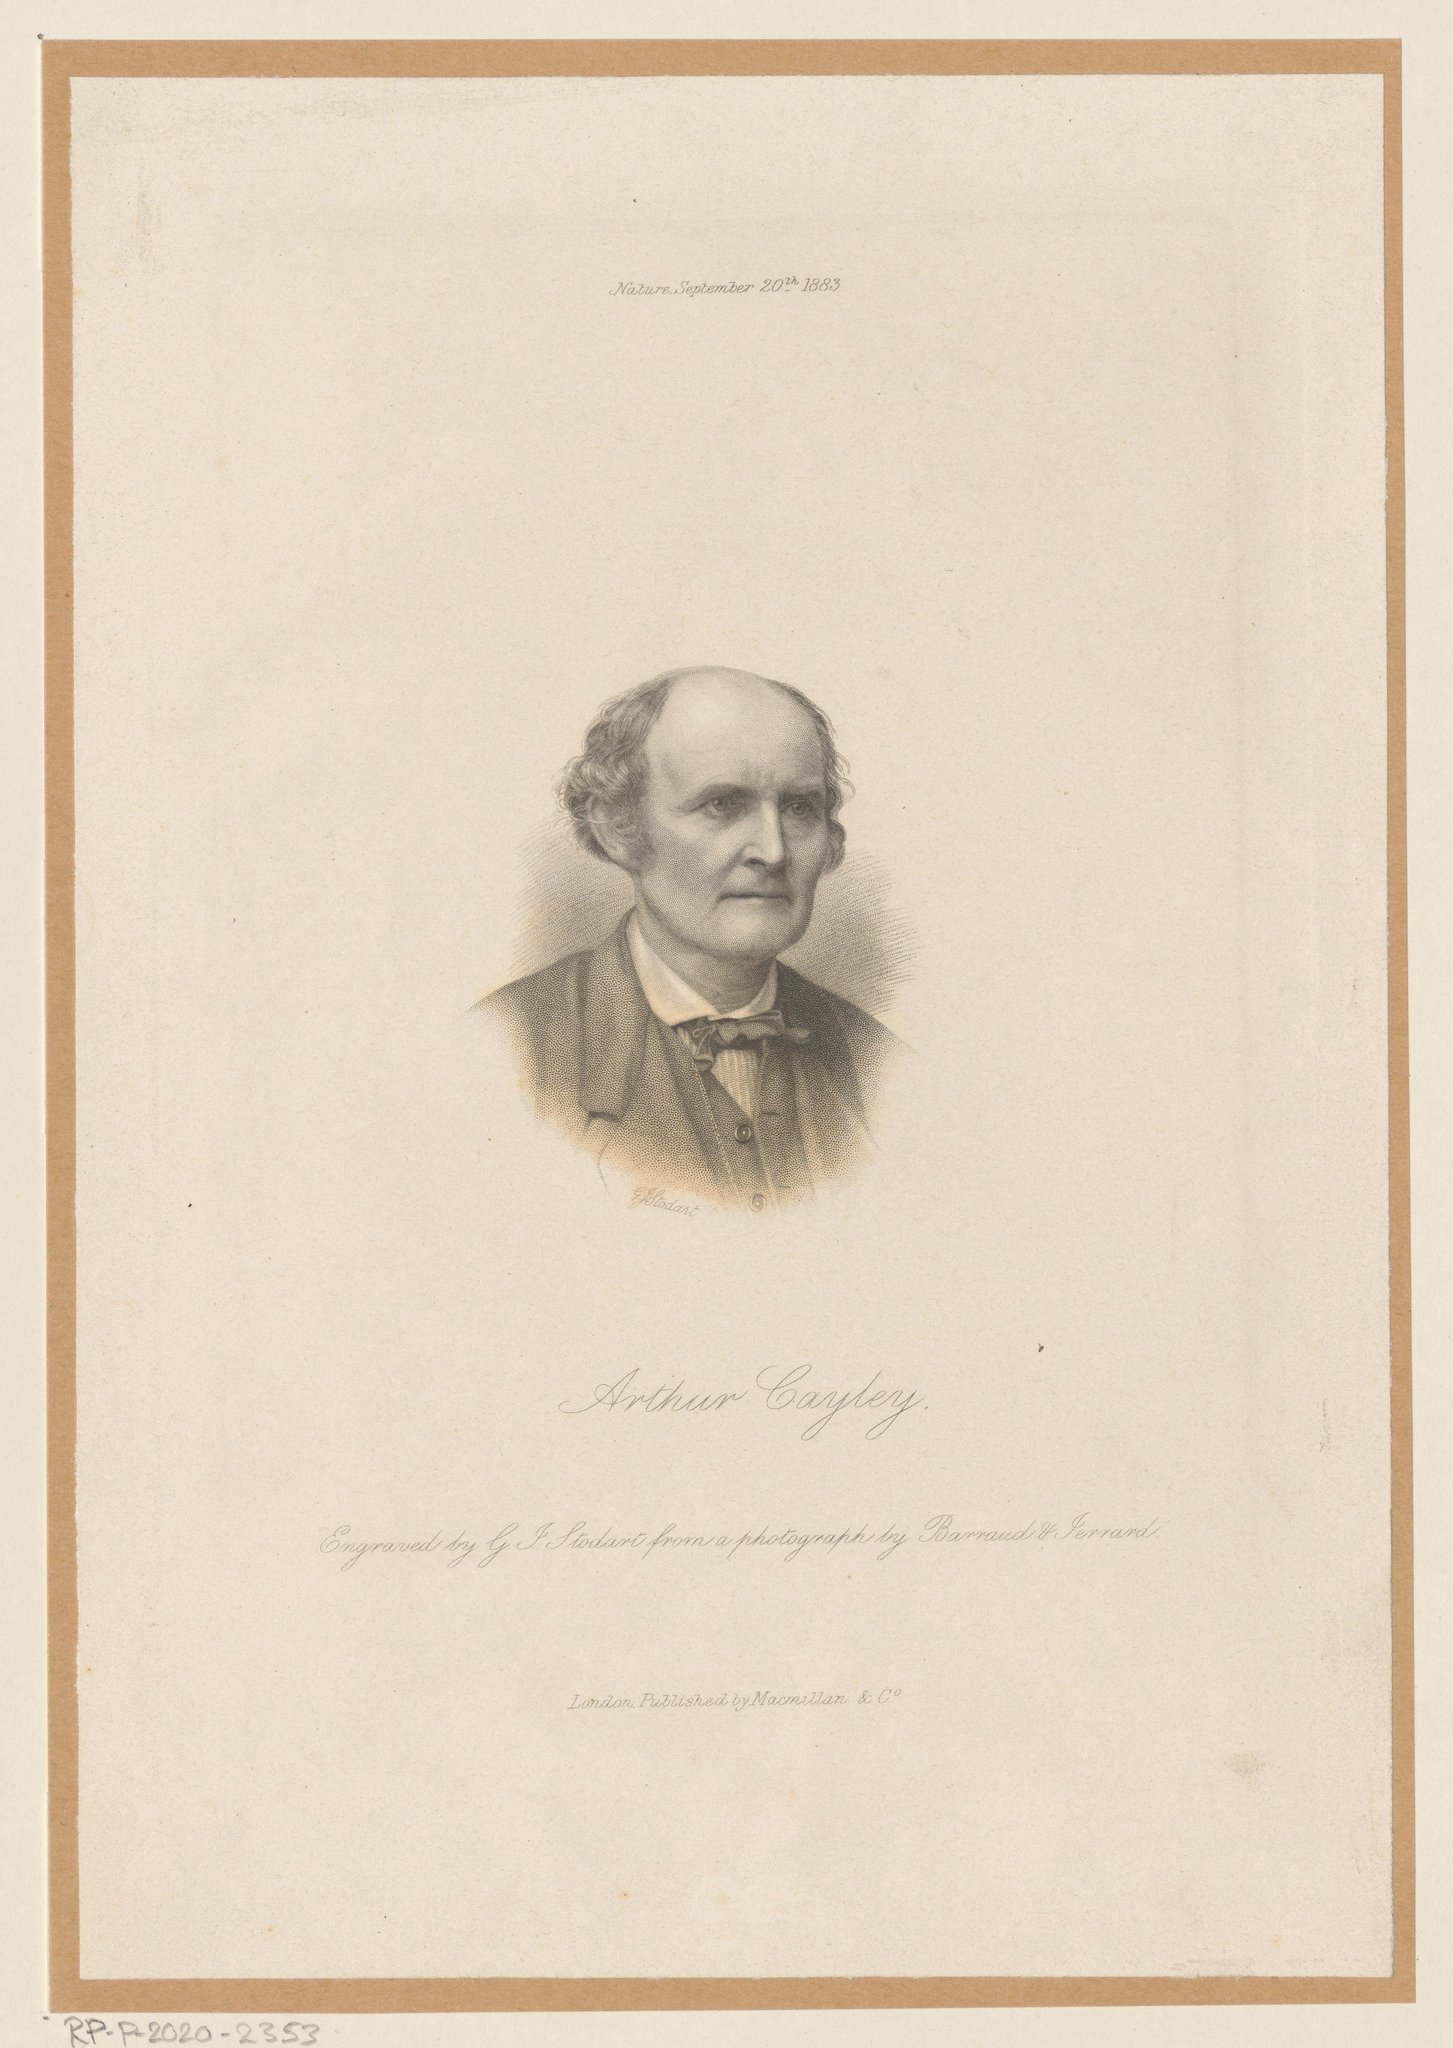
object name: print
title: Portret van Arthur Cayley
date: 1883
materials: paper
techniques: engraving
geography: london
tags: historical persons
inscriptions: date